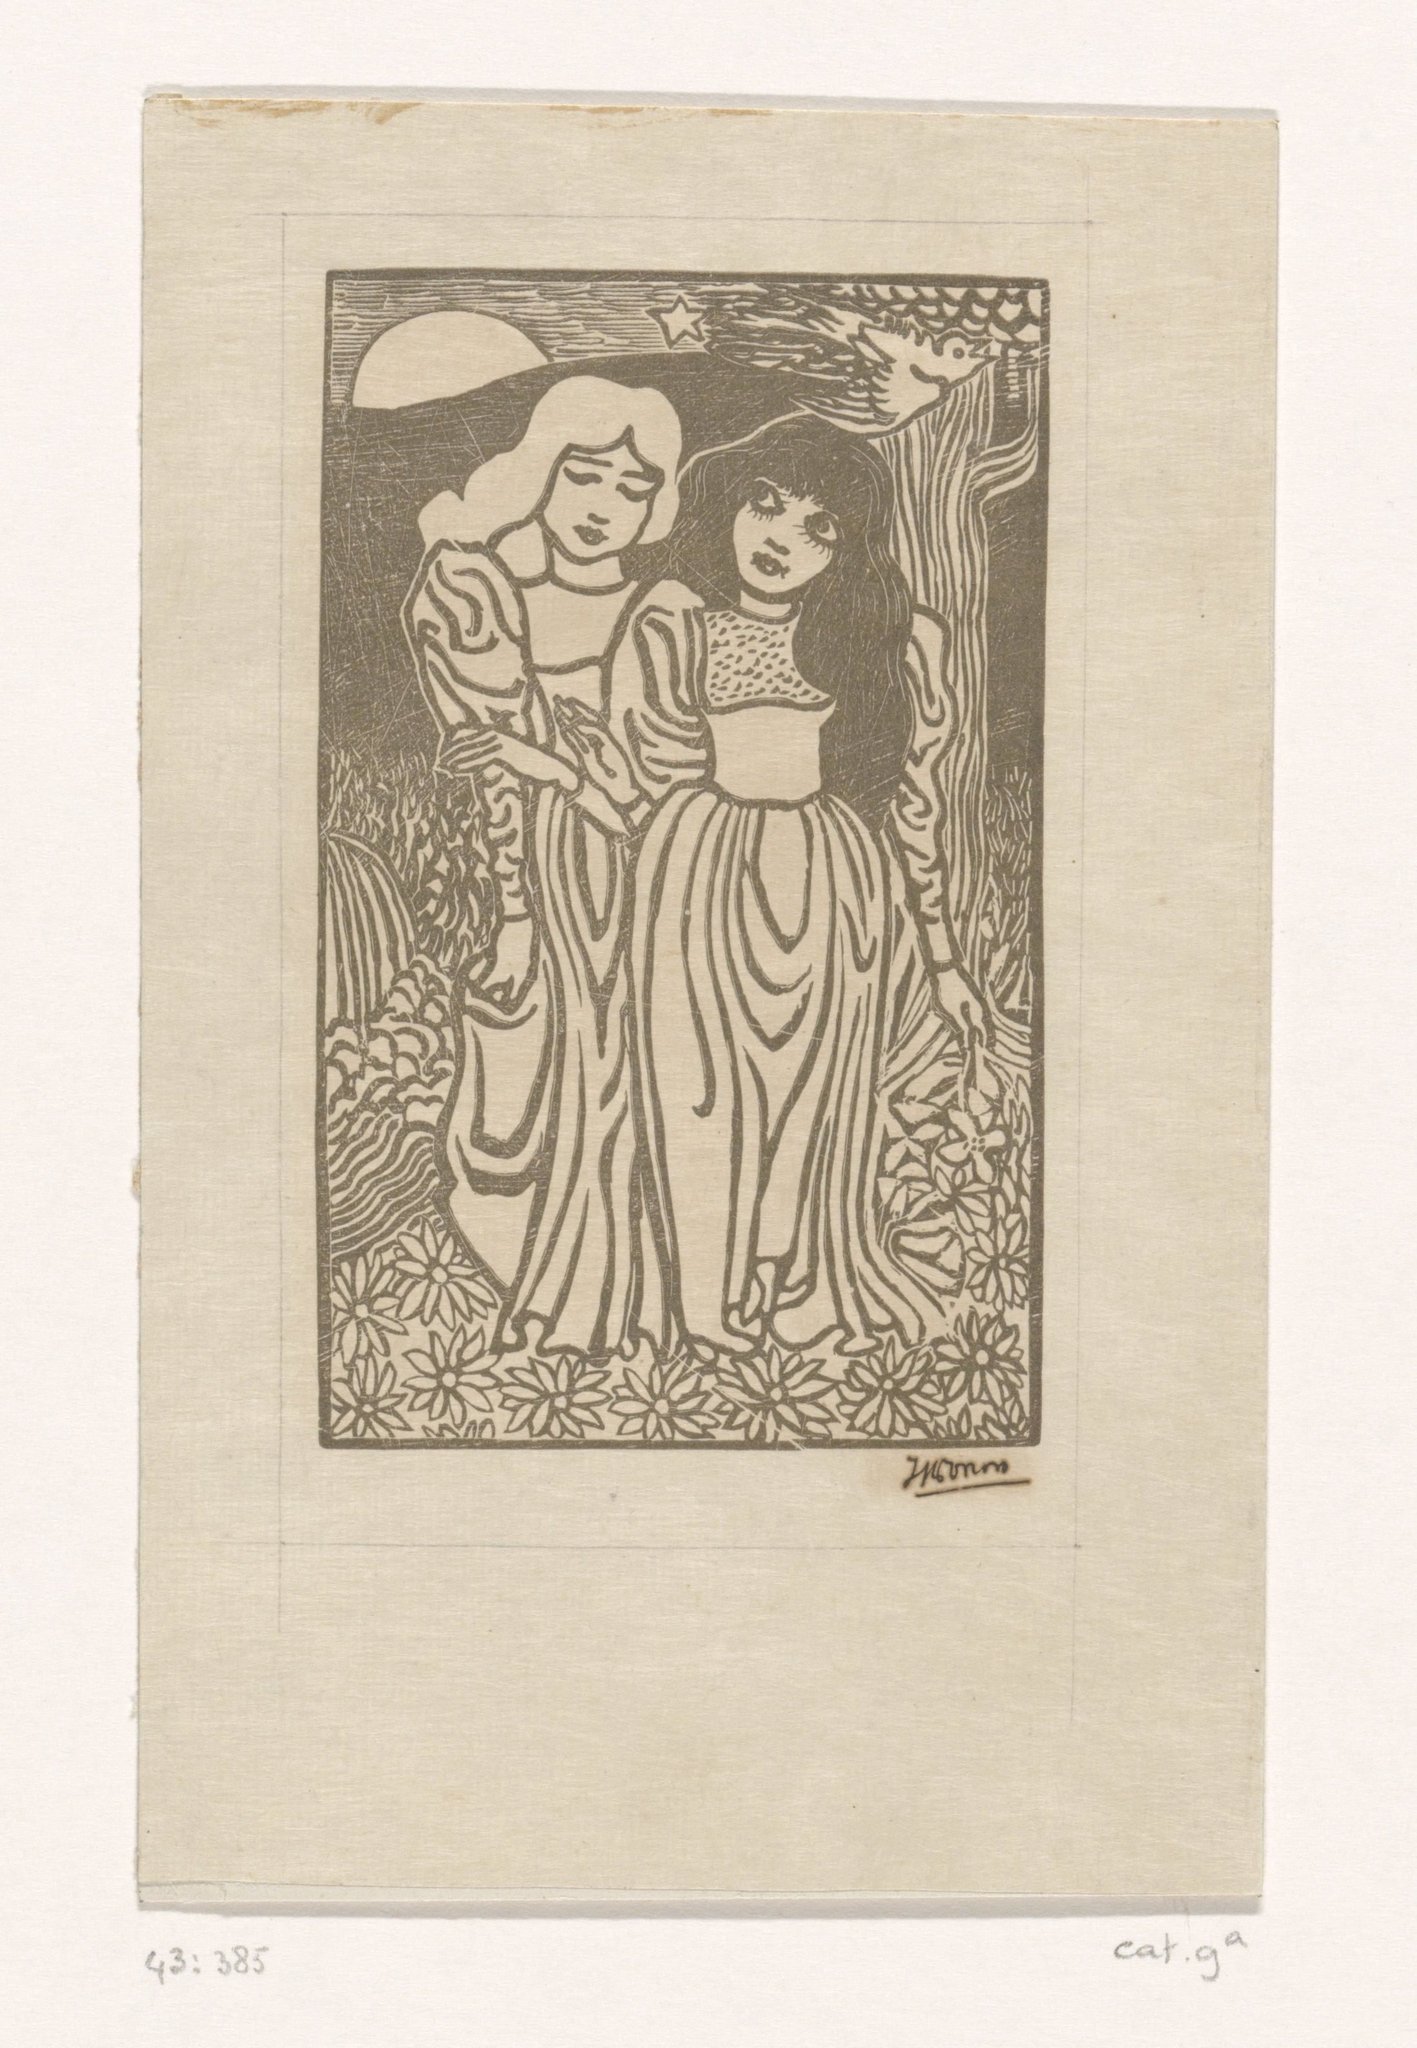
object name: print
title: Twee meisjes in een landschap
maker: jan toorop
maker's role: draughtsman, painter, print maker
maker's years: 1858-1928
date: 1895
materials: paper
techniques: woodcut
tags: park, girl (child between toddler and youth)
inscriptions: collector's mark: Lugt 2228